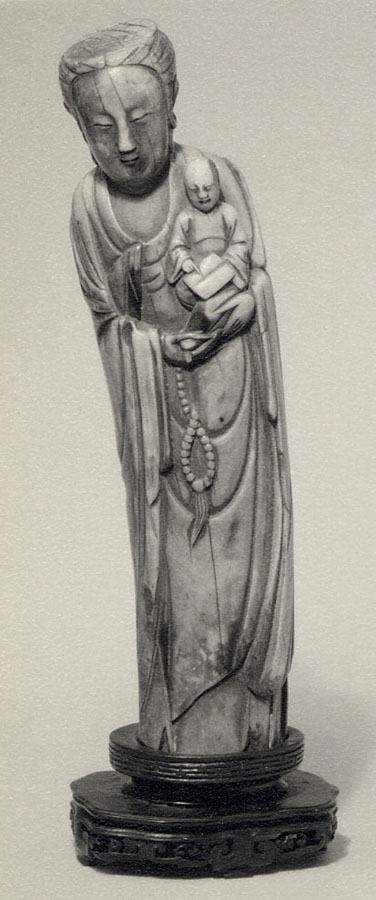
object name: statuette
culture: chinese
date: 1368-1644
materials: ivory, wood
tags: human figures,infants